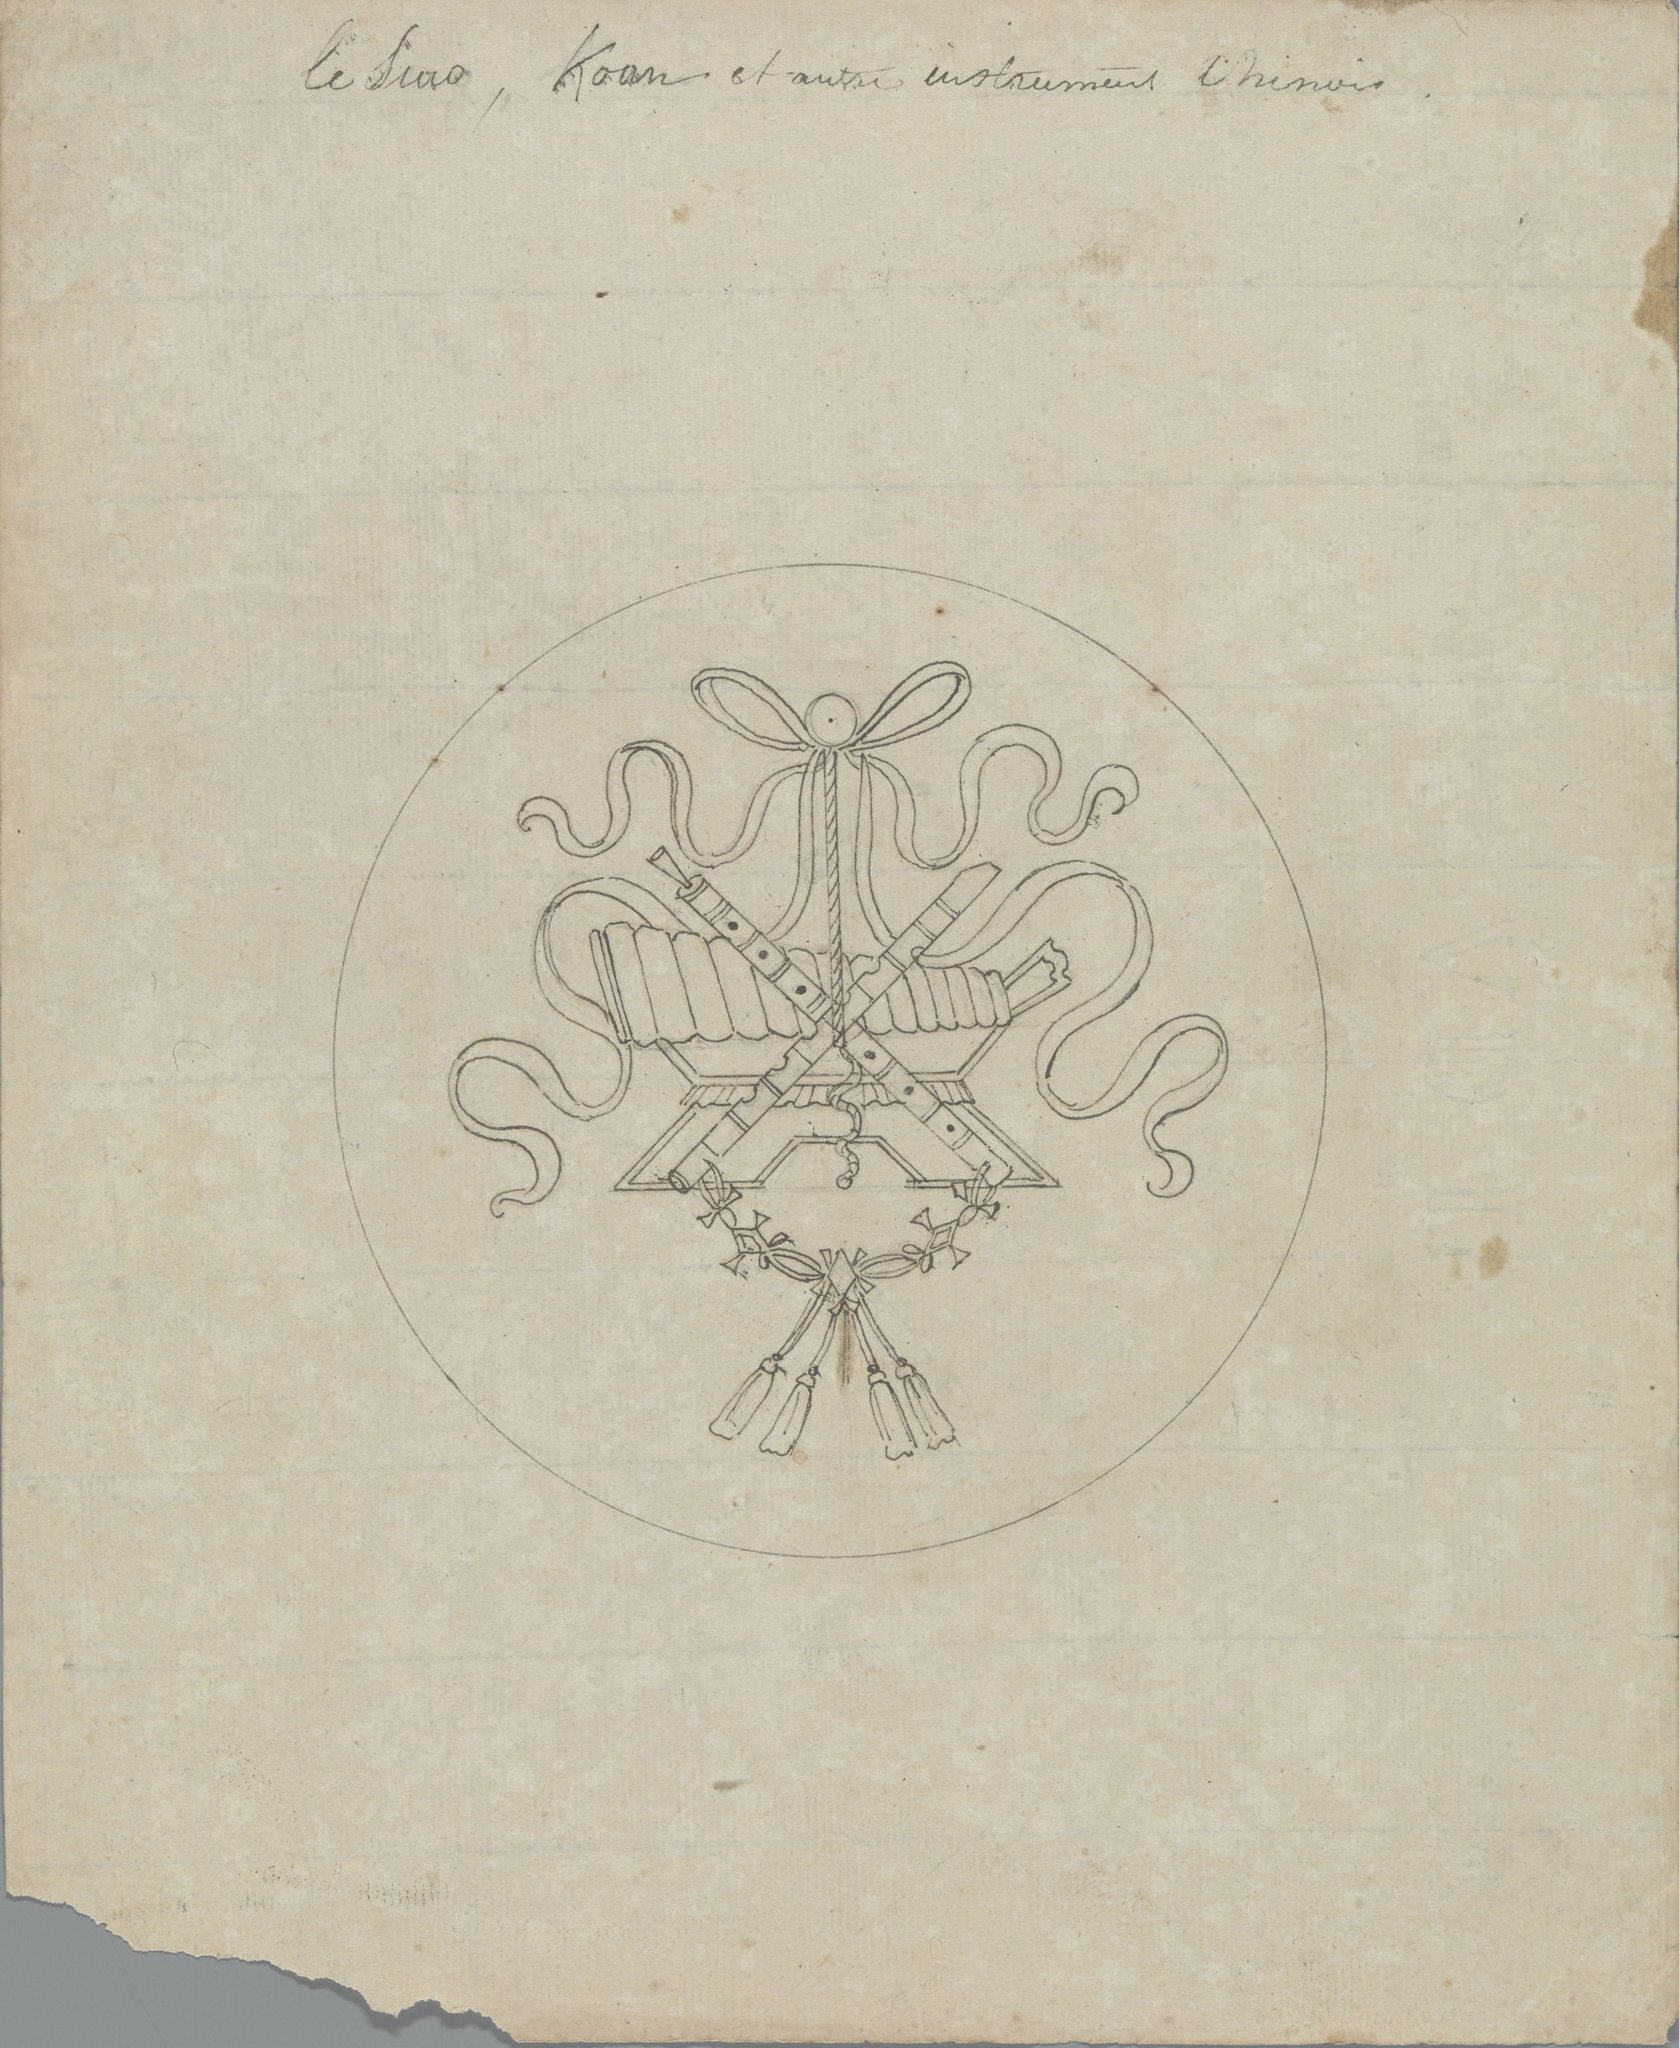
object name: design drawing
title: Le Sino [?], Koan et autre instrument Chinois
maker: pierre félix van doren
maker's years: 1797-1856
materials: graphite, ink, paper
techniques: pen in black ink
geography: brussels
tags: trophy, i.e.: decorative arrangement of symbolic or typical objects ~ ornament, flute, aulos, tibia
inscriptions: watermark: ‘VDL’, inscription: ‘le Sino [?], Koan et autre instrument Chinois’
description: Een van 103 ontwerpen voor marqueterie van aan linten opgehangen muziekinstrumenten in ronde medaillons, bestemd voor de set stoelen gemaakt door Van Doren voor de grote zaal van het Paleis van de Prins van Oranje in Brussel in 1828.